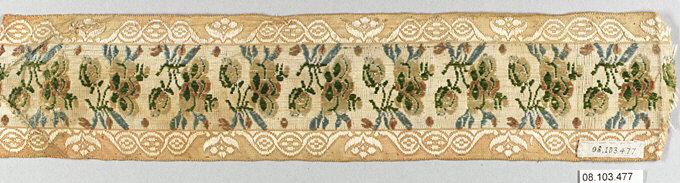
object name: galloon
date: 1830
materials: silk